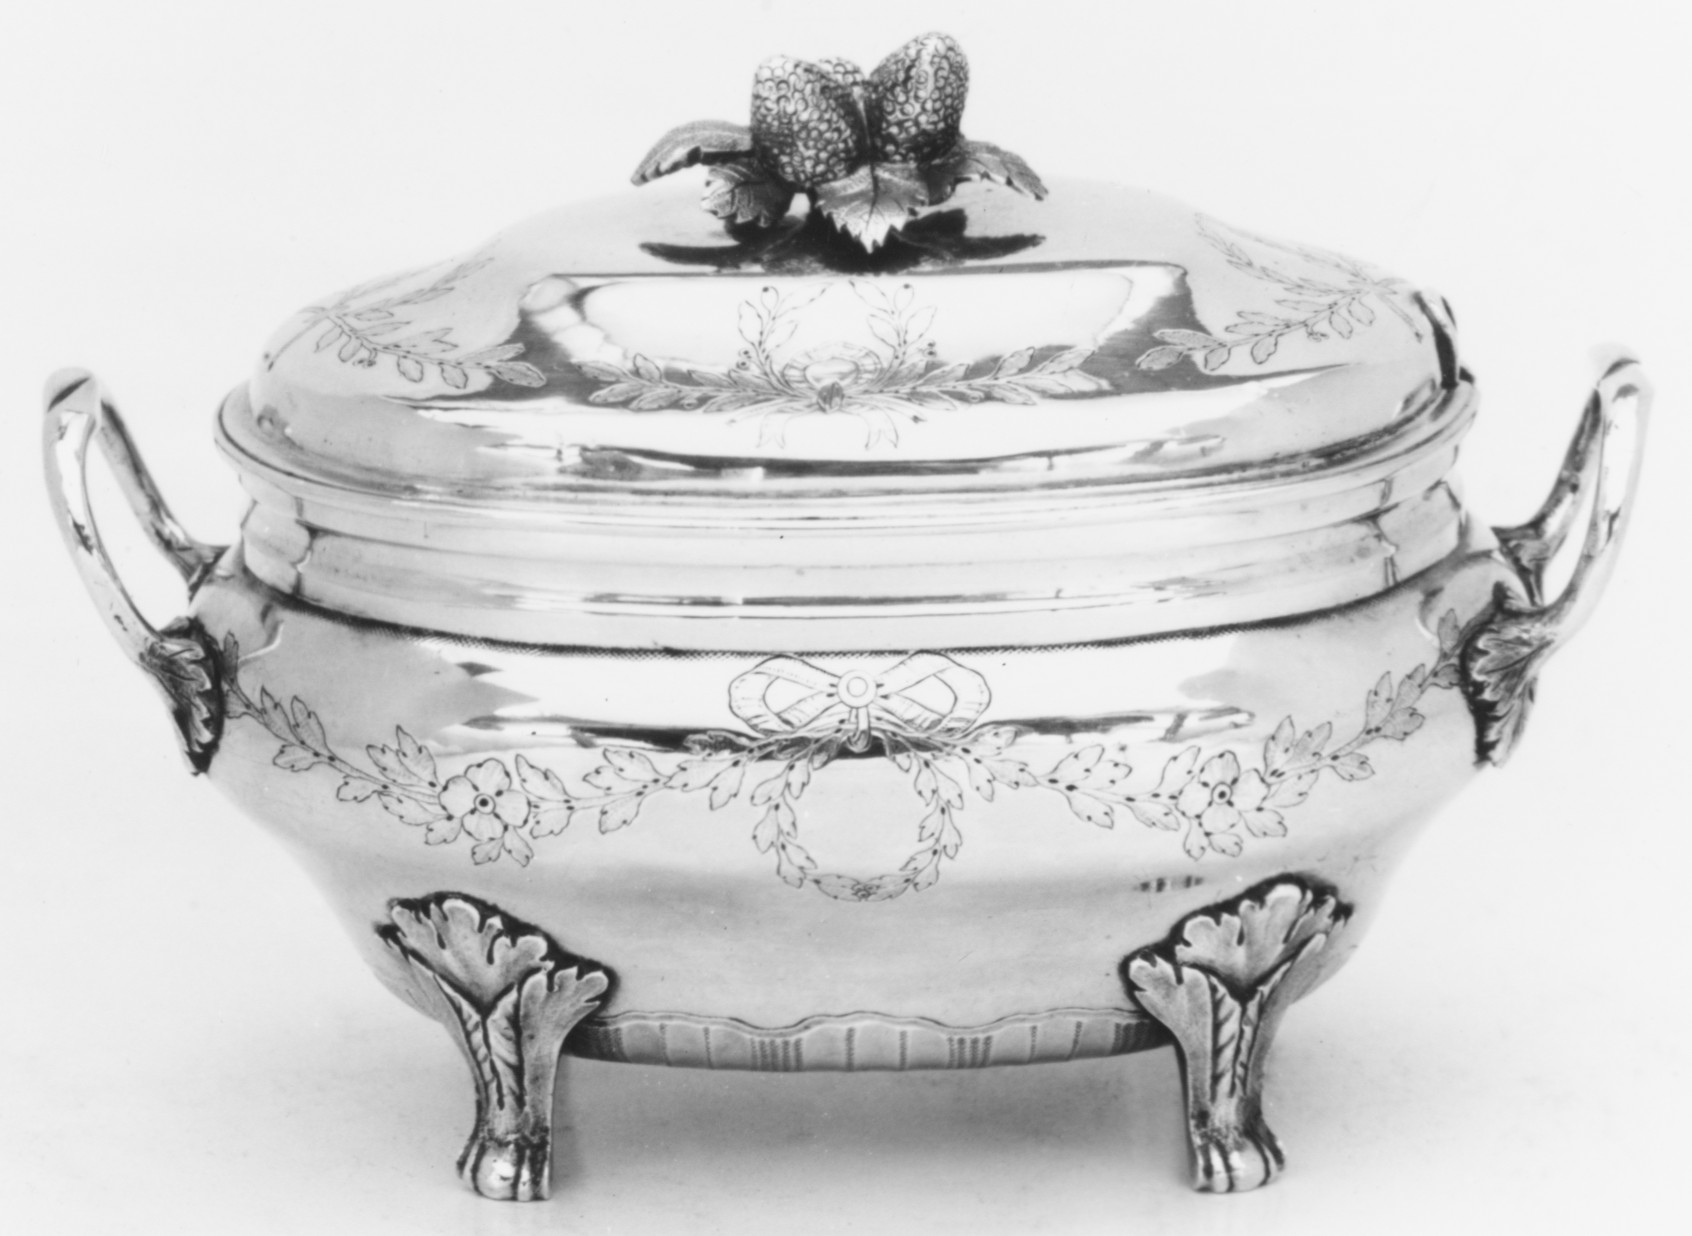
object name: sugar bowl with cover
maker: louis-joseph bouty (called milleraud-bouty)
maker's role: maker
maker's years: 1733-1833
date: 1785-1787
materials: silver